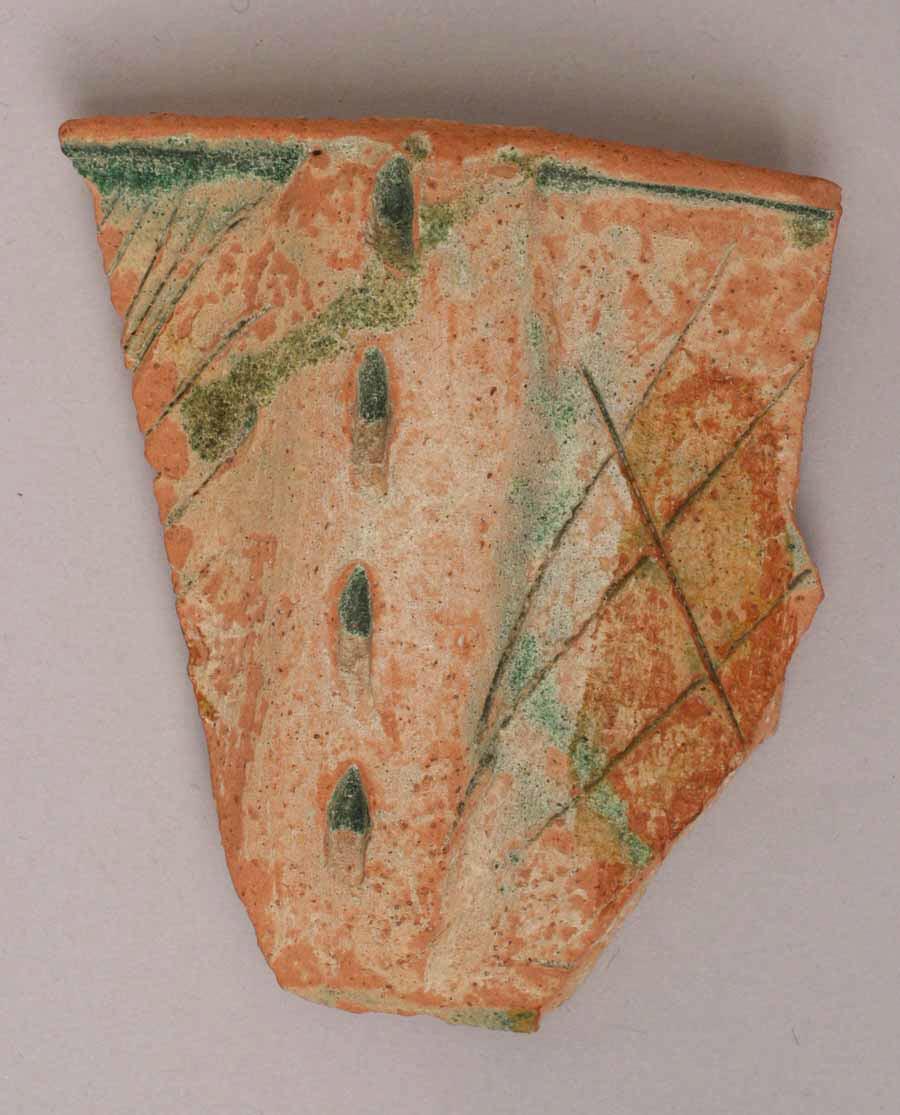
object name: fragment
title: Ceramic Fragment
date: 1001-1100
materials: earthenware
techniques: glazing, incising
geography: saudi arabia